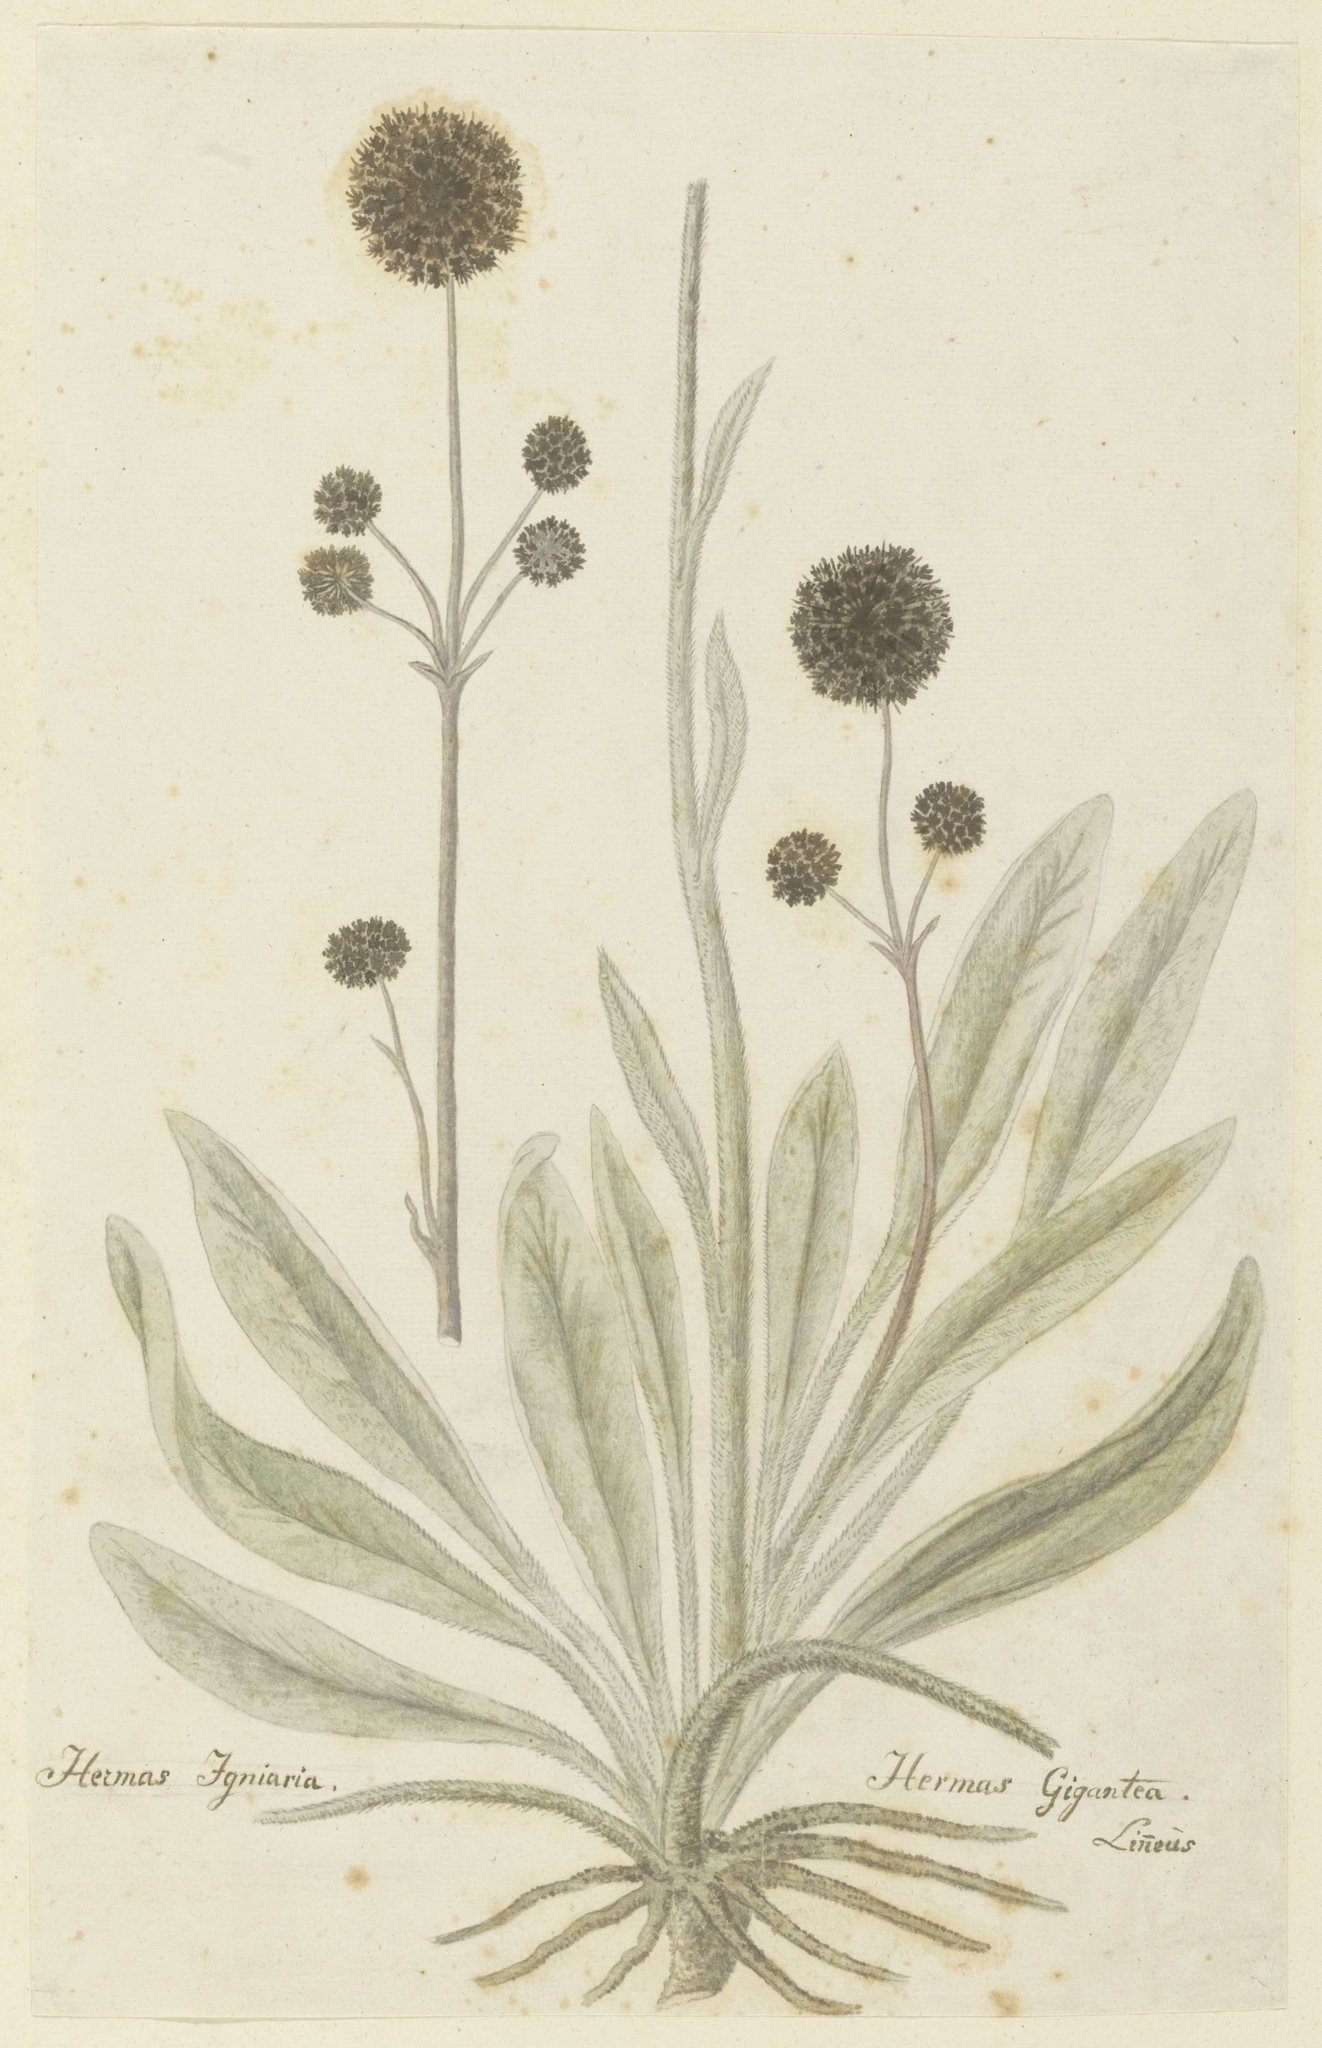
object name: album leaf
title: Hermas igniaria of Hermas gigantea (Tontelblaar)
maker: robert jacob gordon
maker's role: draughtsman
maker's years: 1743-1795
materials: chalk, ink, paper, pencil, watercolor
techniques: brush, pen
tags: plants; vegetation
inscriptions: annotation: ‘Hermas Igniaria. en Hermas Gigantea. / Lineus’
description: De tekening is gemaakt voor of tijdens een van Gordon's vier expedities door de Kaapprovincie, van oktober 1777 tot maart 1786. Sommige (soort)namen kunnen zijn gewijzigd, gezien de reorganisatie in plantentaxonomie gedurende de afgelopen jaren.